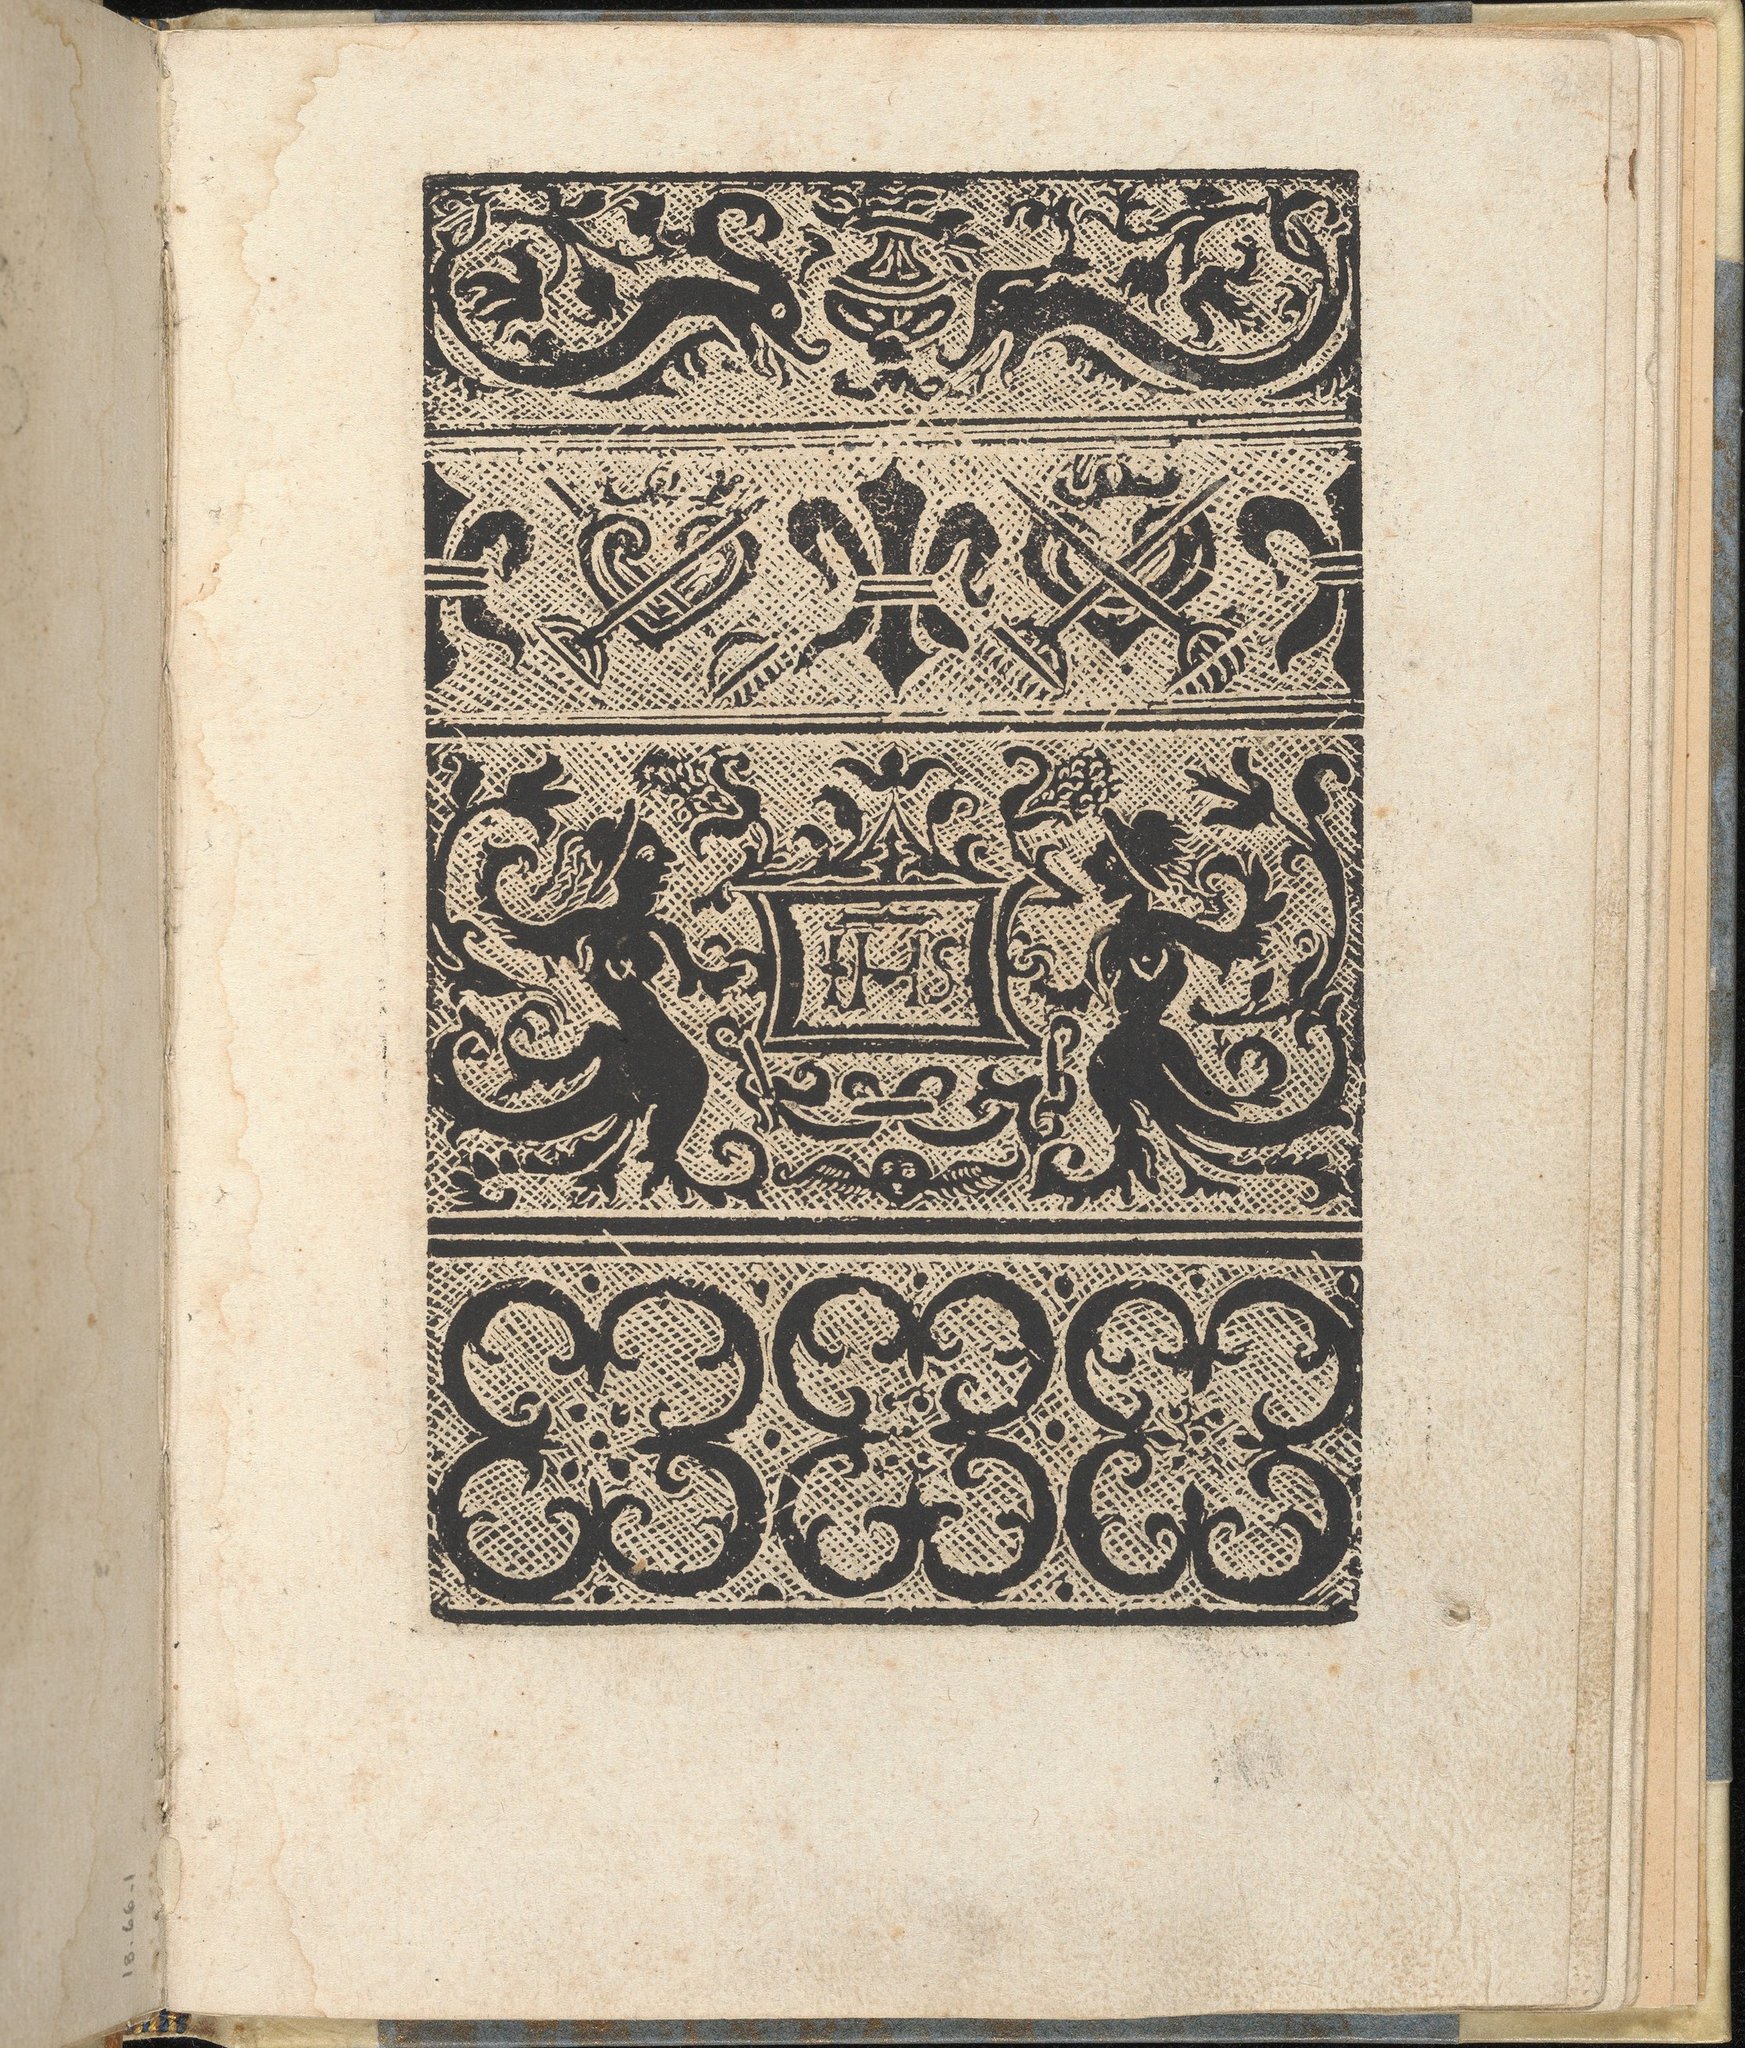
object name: book print ornament architecture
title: Ein ney Furmbüchlein, Page 2, recto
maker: johann schönsperger the younger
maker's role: publisher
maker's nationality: german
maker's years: 1490-1550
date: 1525-1529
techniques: woodcut